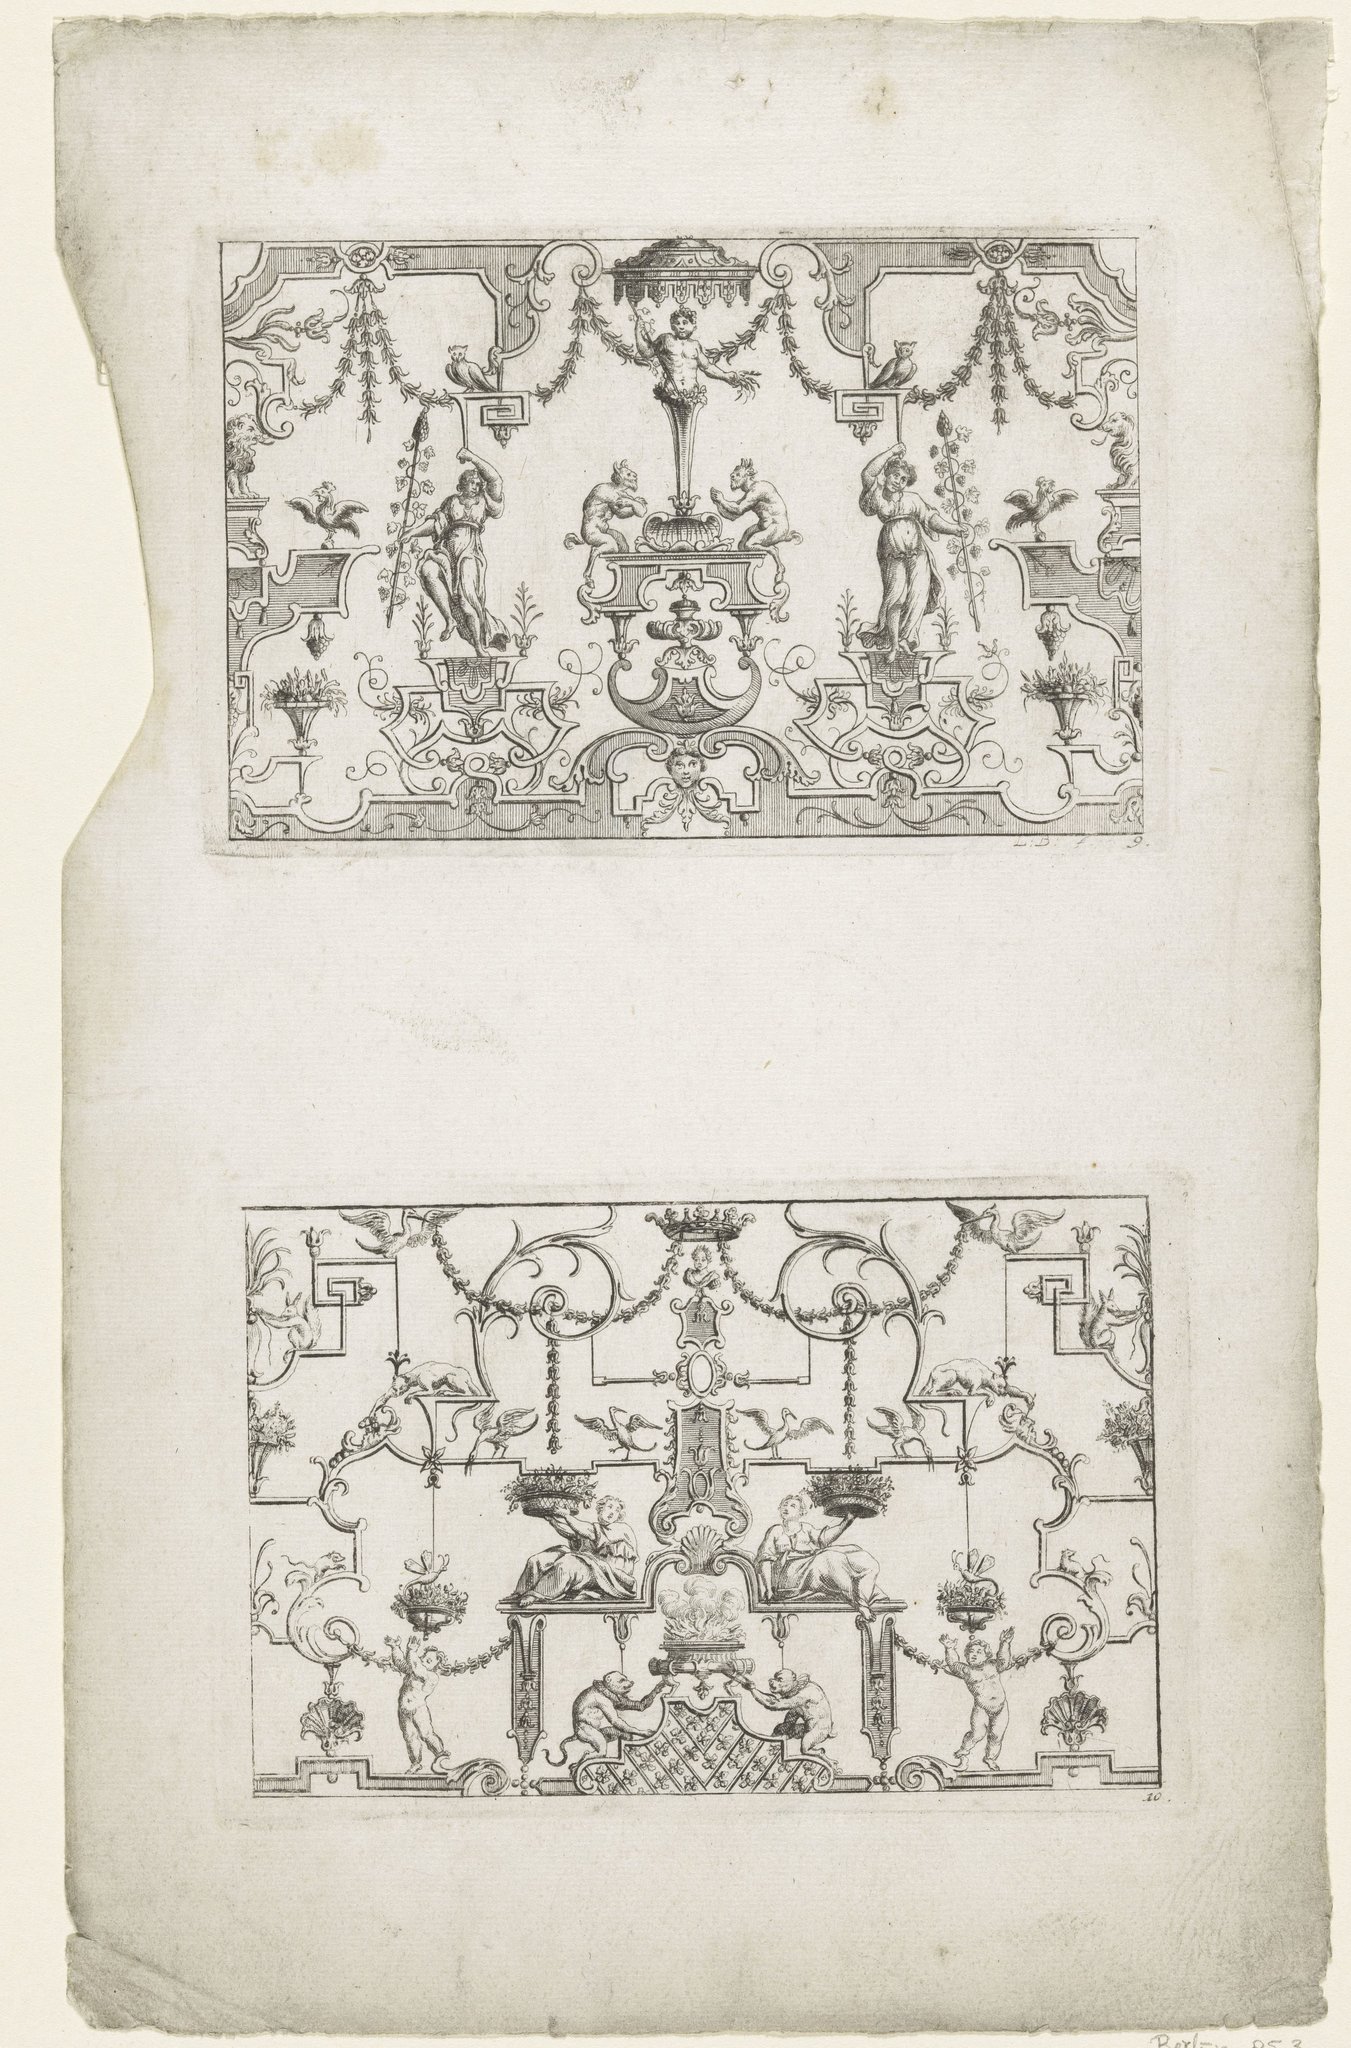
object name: print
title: Grotesken met Bacchus en vrouwenfiguren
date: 1687-1725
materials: paper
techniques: etching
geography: germany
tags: ornament ~ grotesque, (story of) bacchus (dionysus), liber, monkeys, apes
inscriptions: collector's mark: Lugt 2228, collector's mark: Lugt 2760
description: De bovenste prent bevat in het midden Bacchus onder een baldakijn met twee saters. Links en rechts een vrouwenfiguur met een thyrsus. De onderste prent bevat twee zittende vrouwen met een bloemenmand, putti en apen met een rookvat.